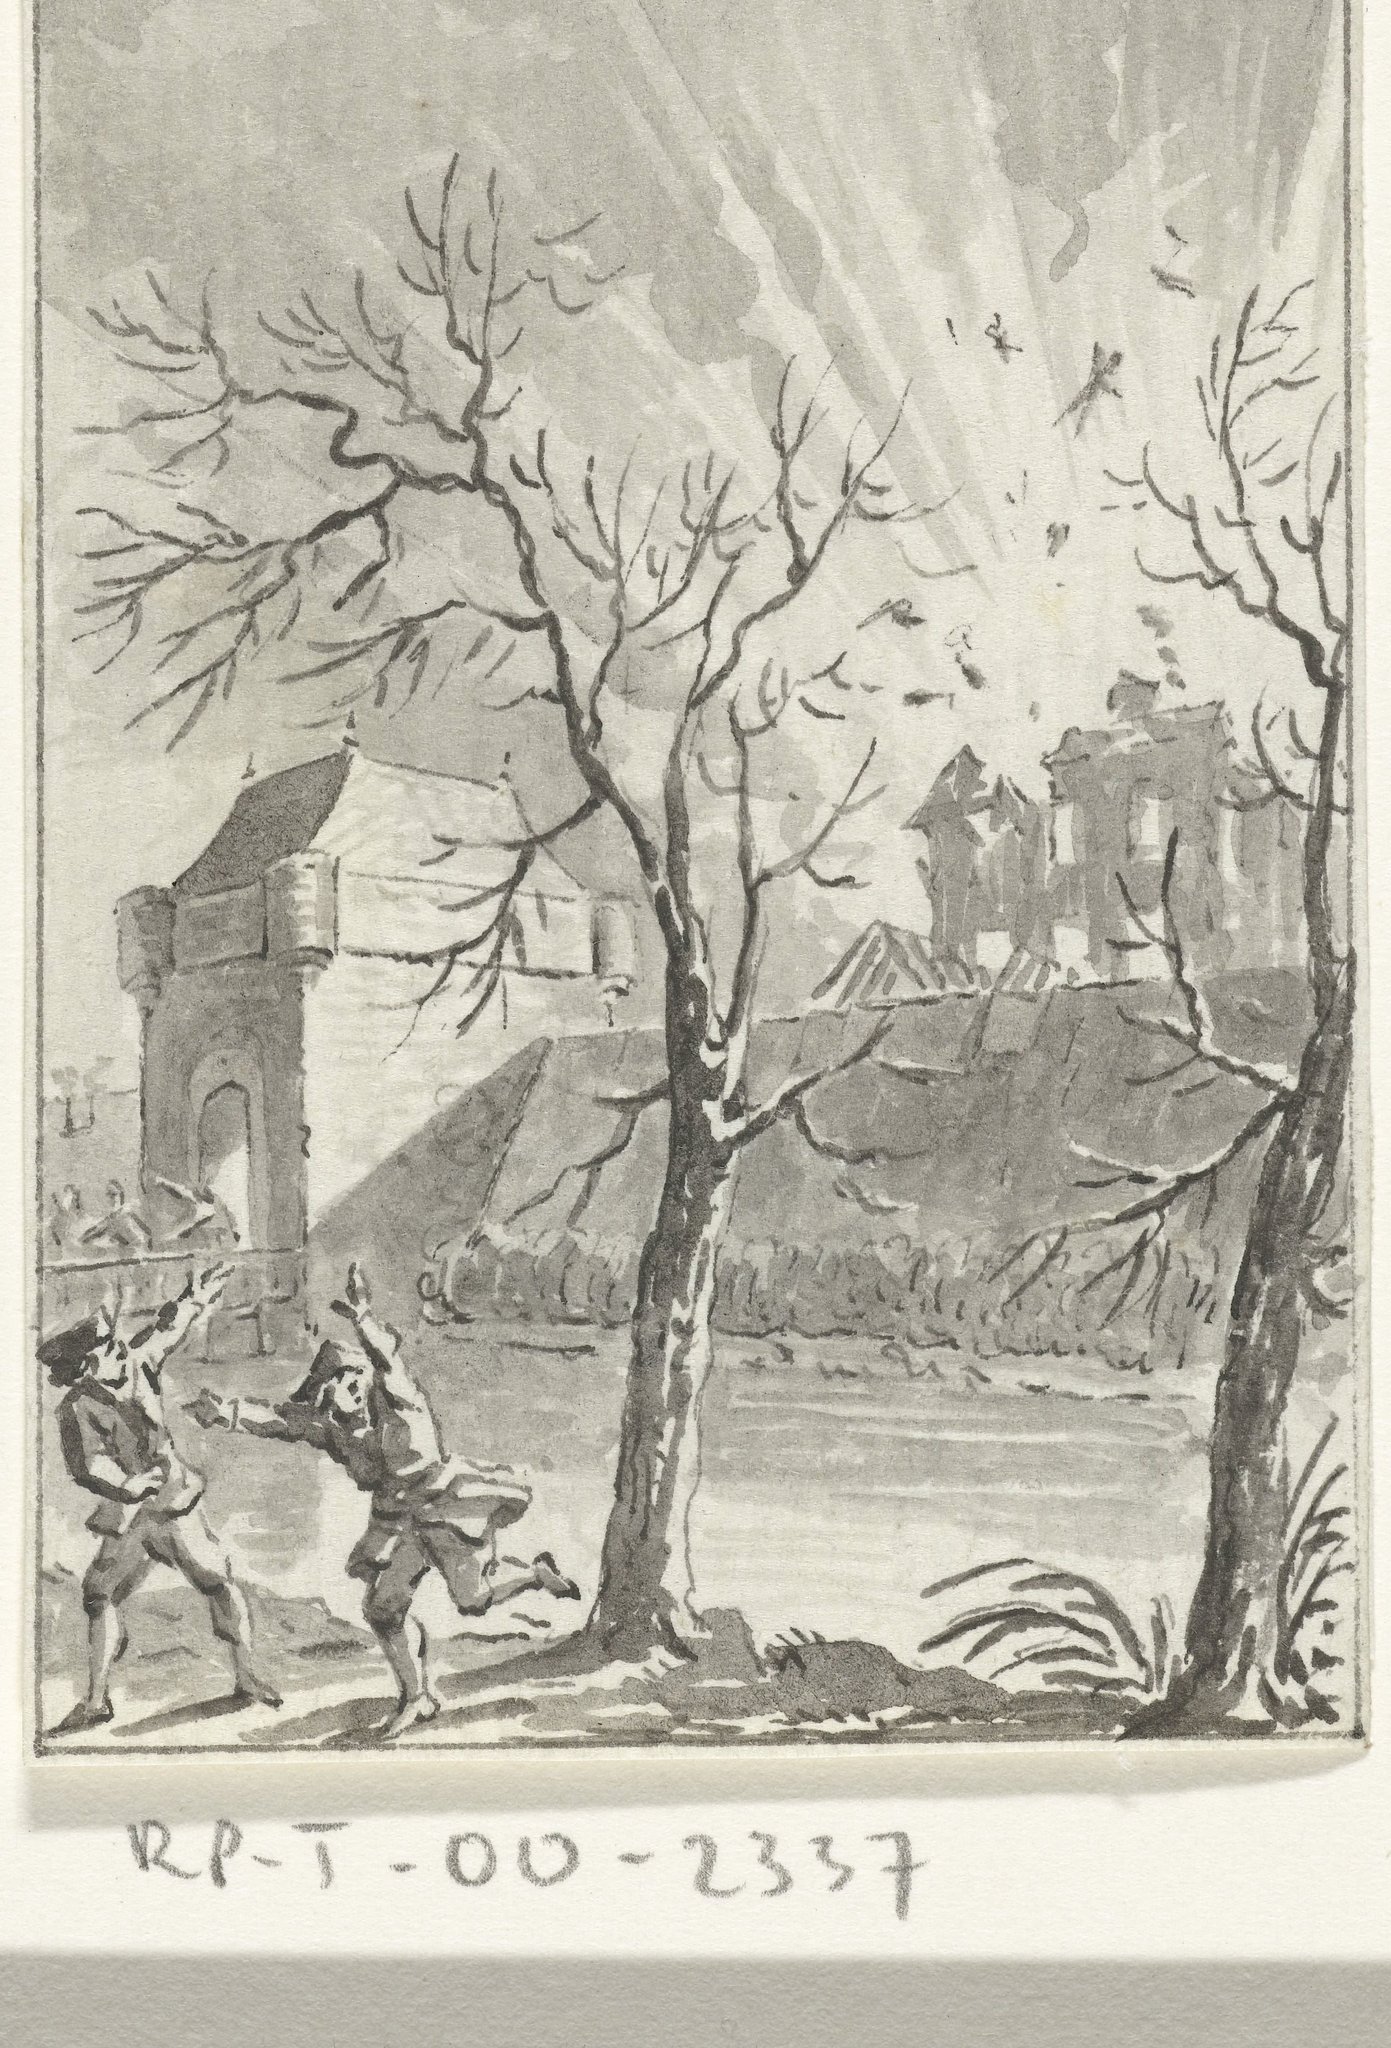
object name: drawing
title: Ontploffing van het kruitmagazijn te Maastricht, 21 december 1761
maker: jacobus buys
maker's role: draughtsman, print maker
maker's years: 1724-1801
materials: ink, paper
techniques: brush, pen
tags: historical events and situations, gunpowder disaster, maastricht